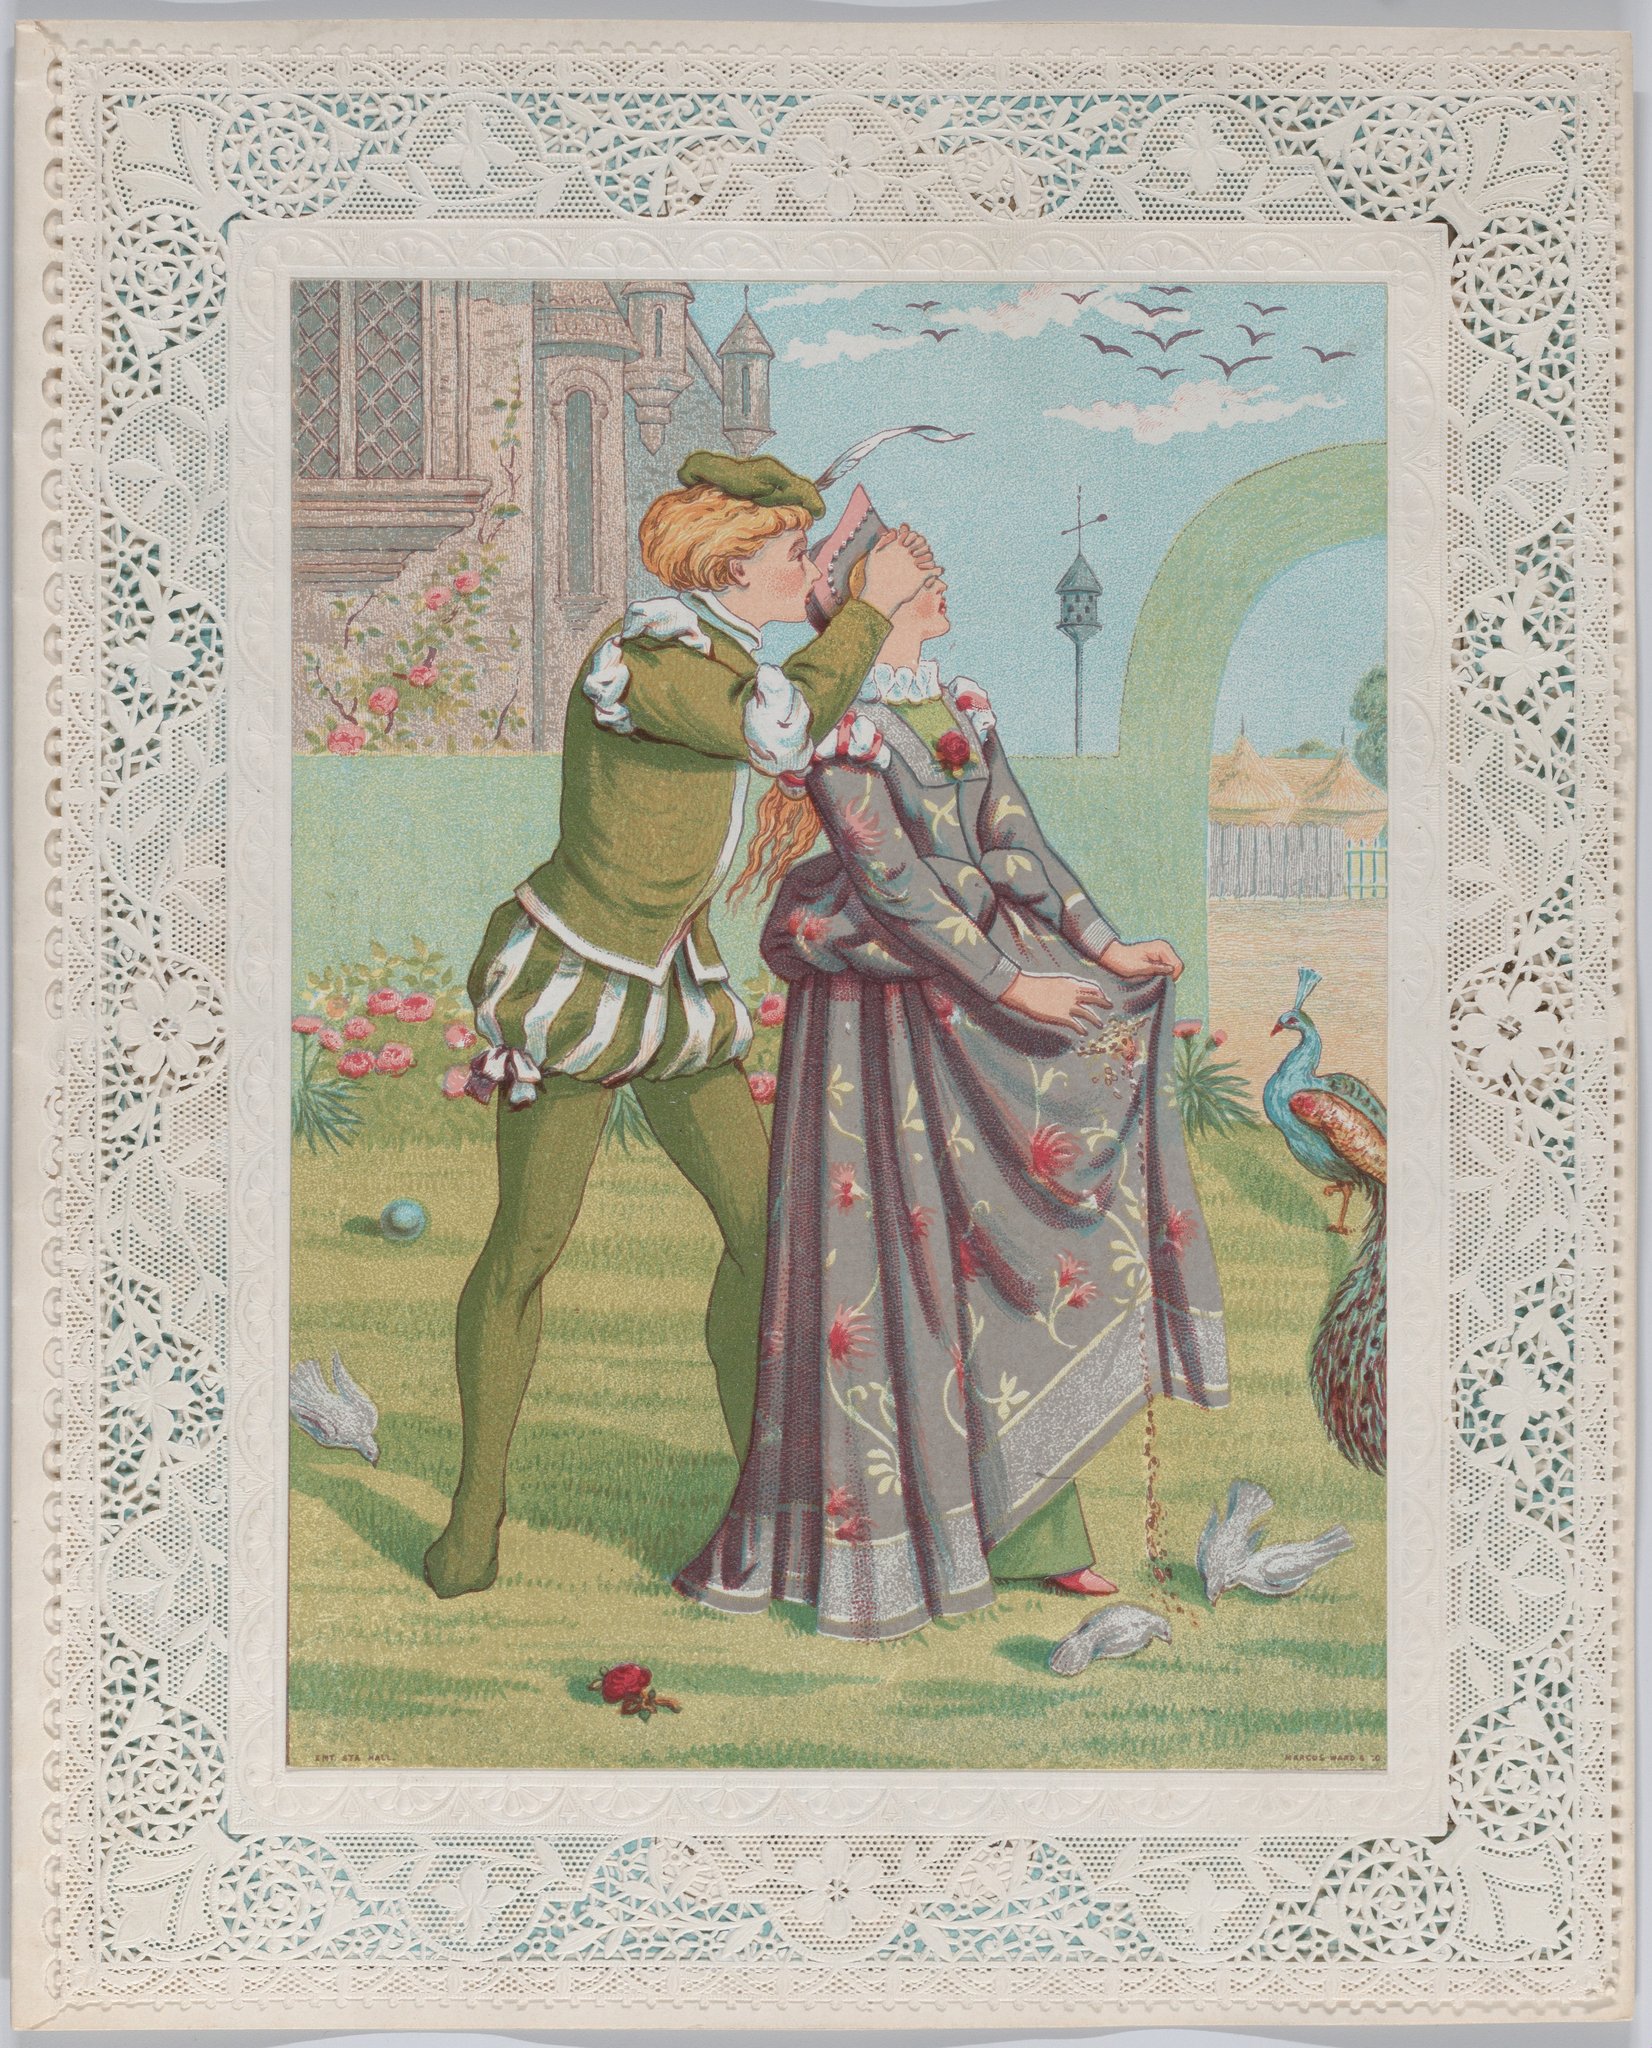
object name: valentine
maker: kate greenaway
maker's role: artist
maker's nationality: british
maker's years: 1846-1901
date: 1876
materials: gold, lace, paper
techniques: chromolithography, gilding, lithograph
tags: couples,men,women